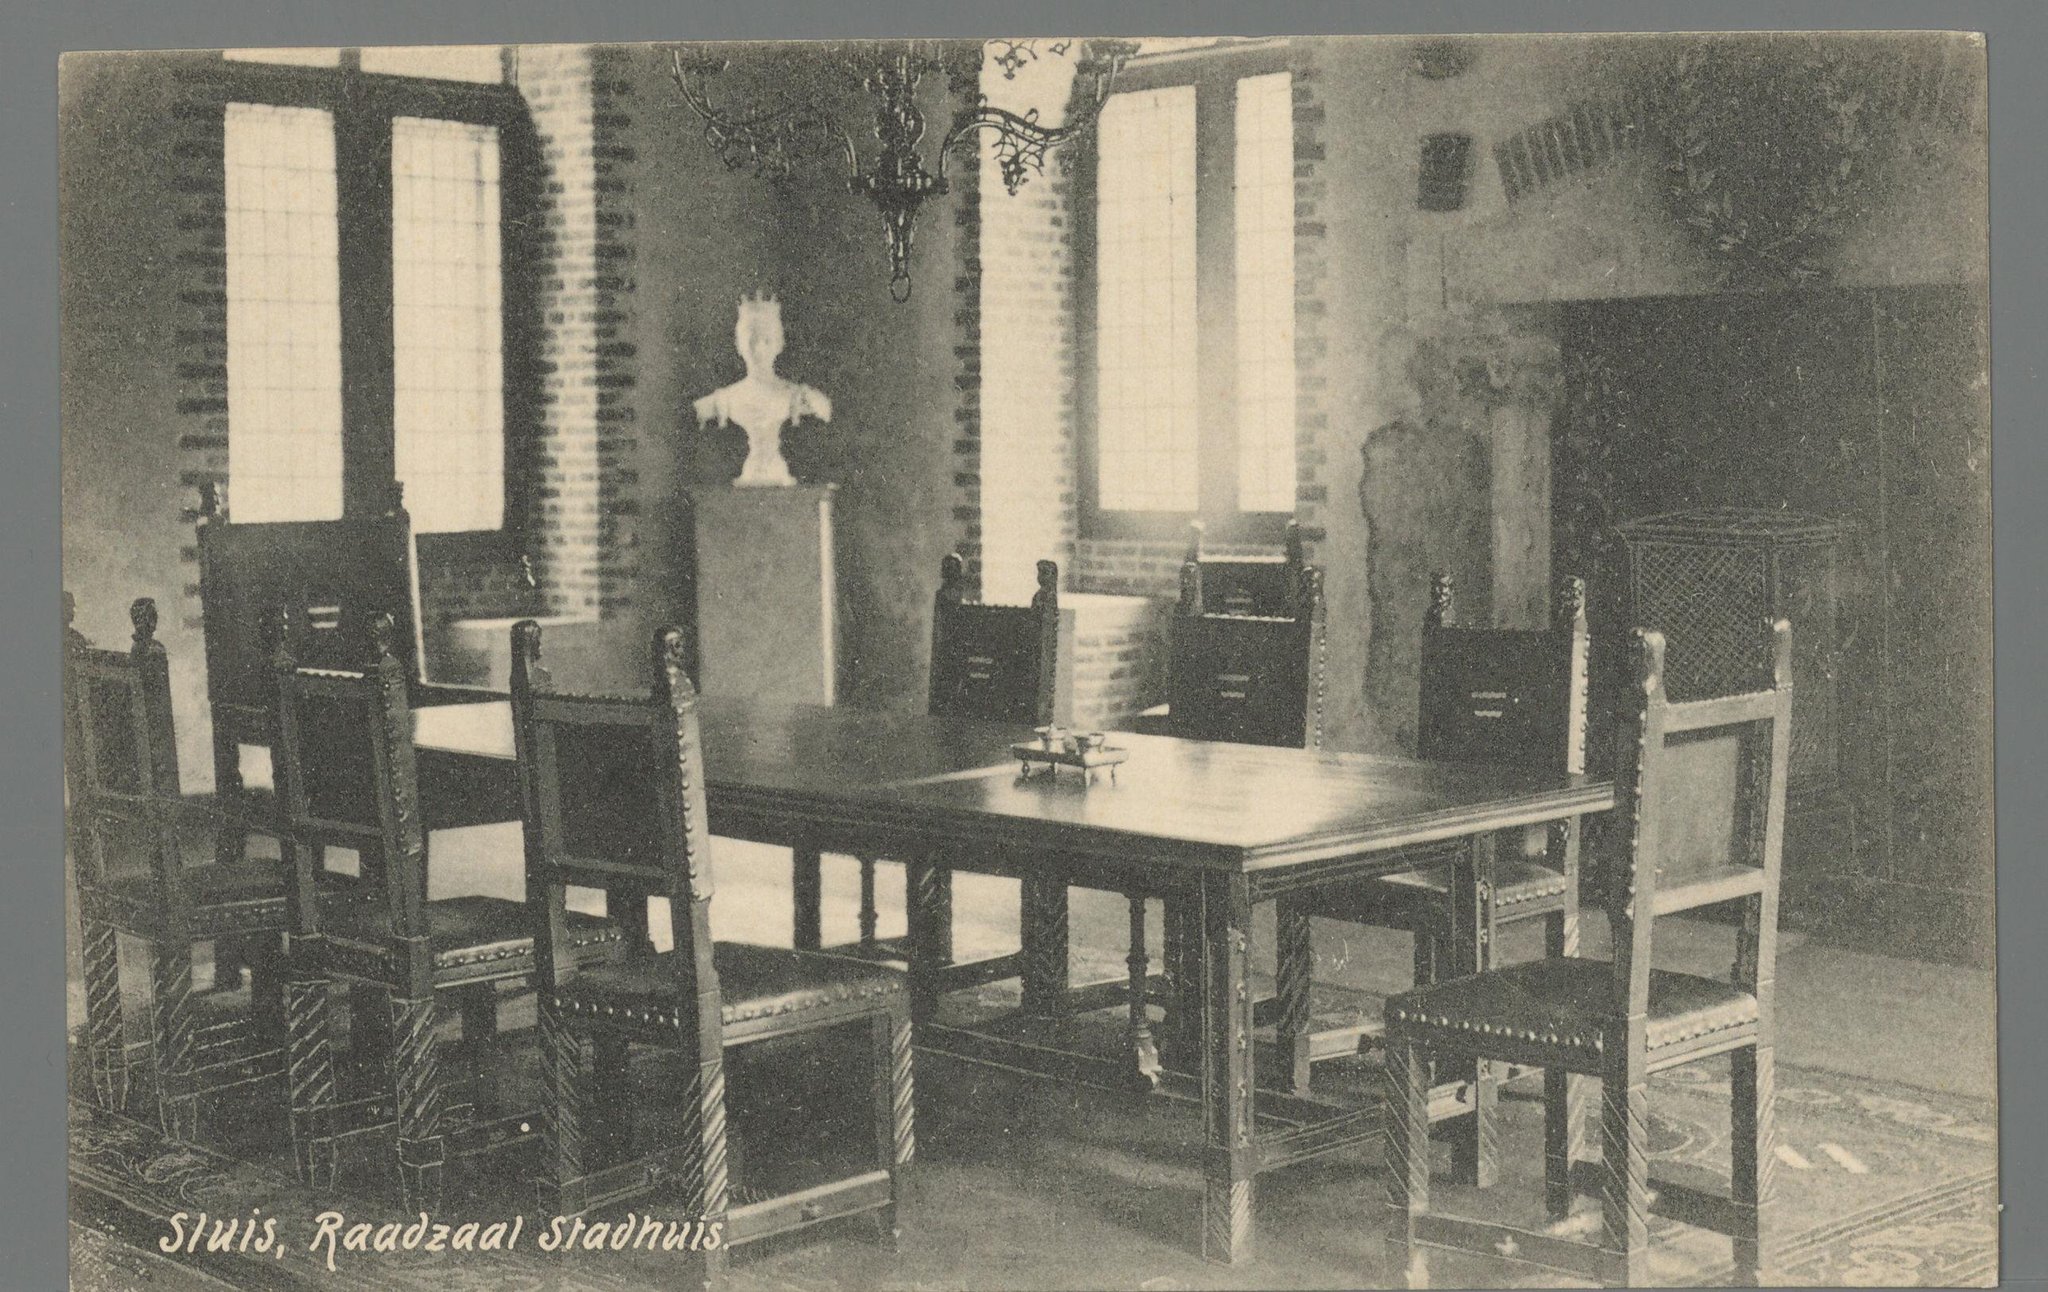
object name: photomechanical print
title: Sluis, Raadzaal Stadhuis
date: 1905-1930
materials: cardboard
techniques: photograph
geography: sluis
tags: townhall, interior of the house